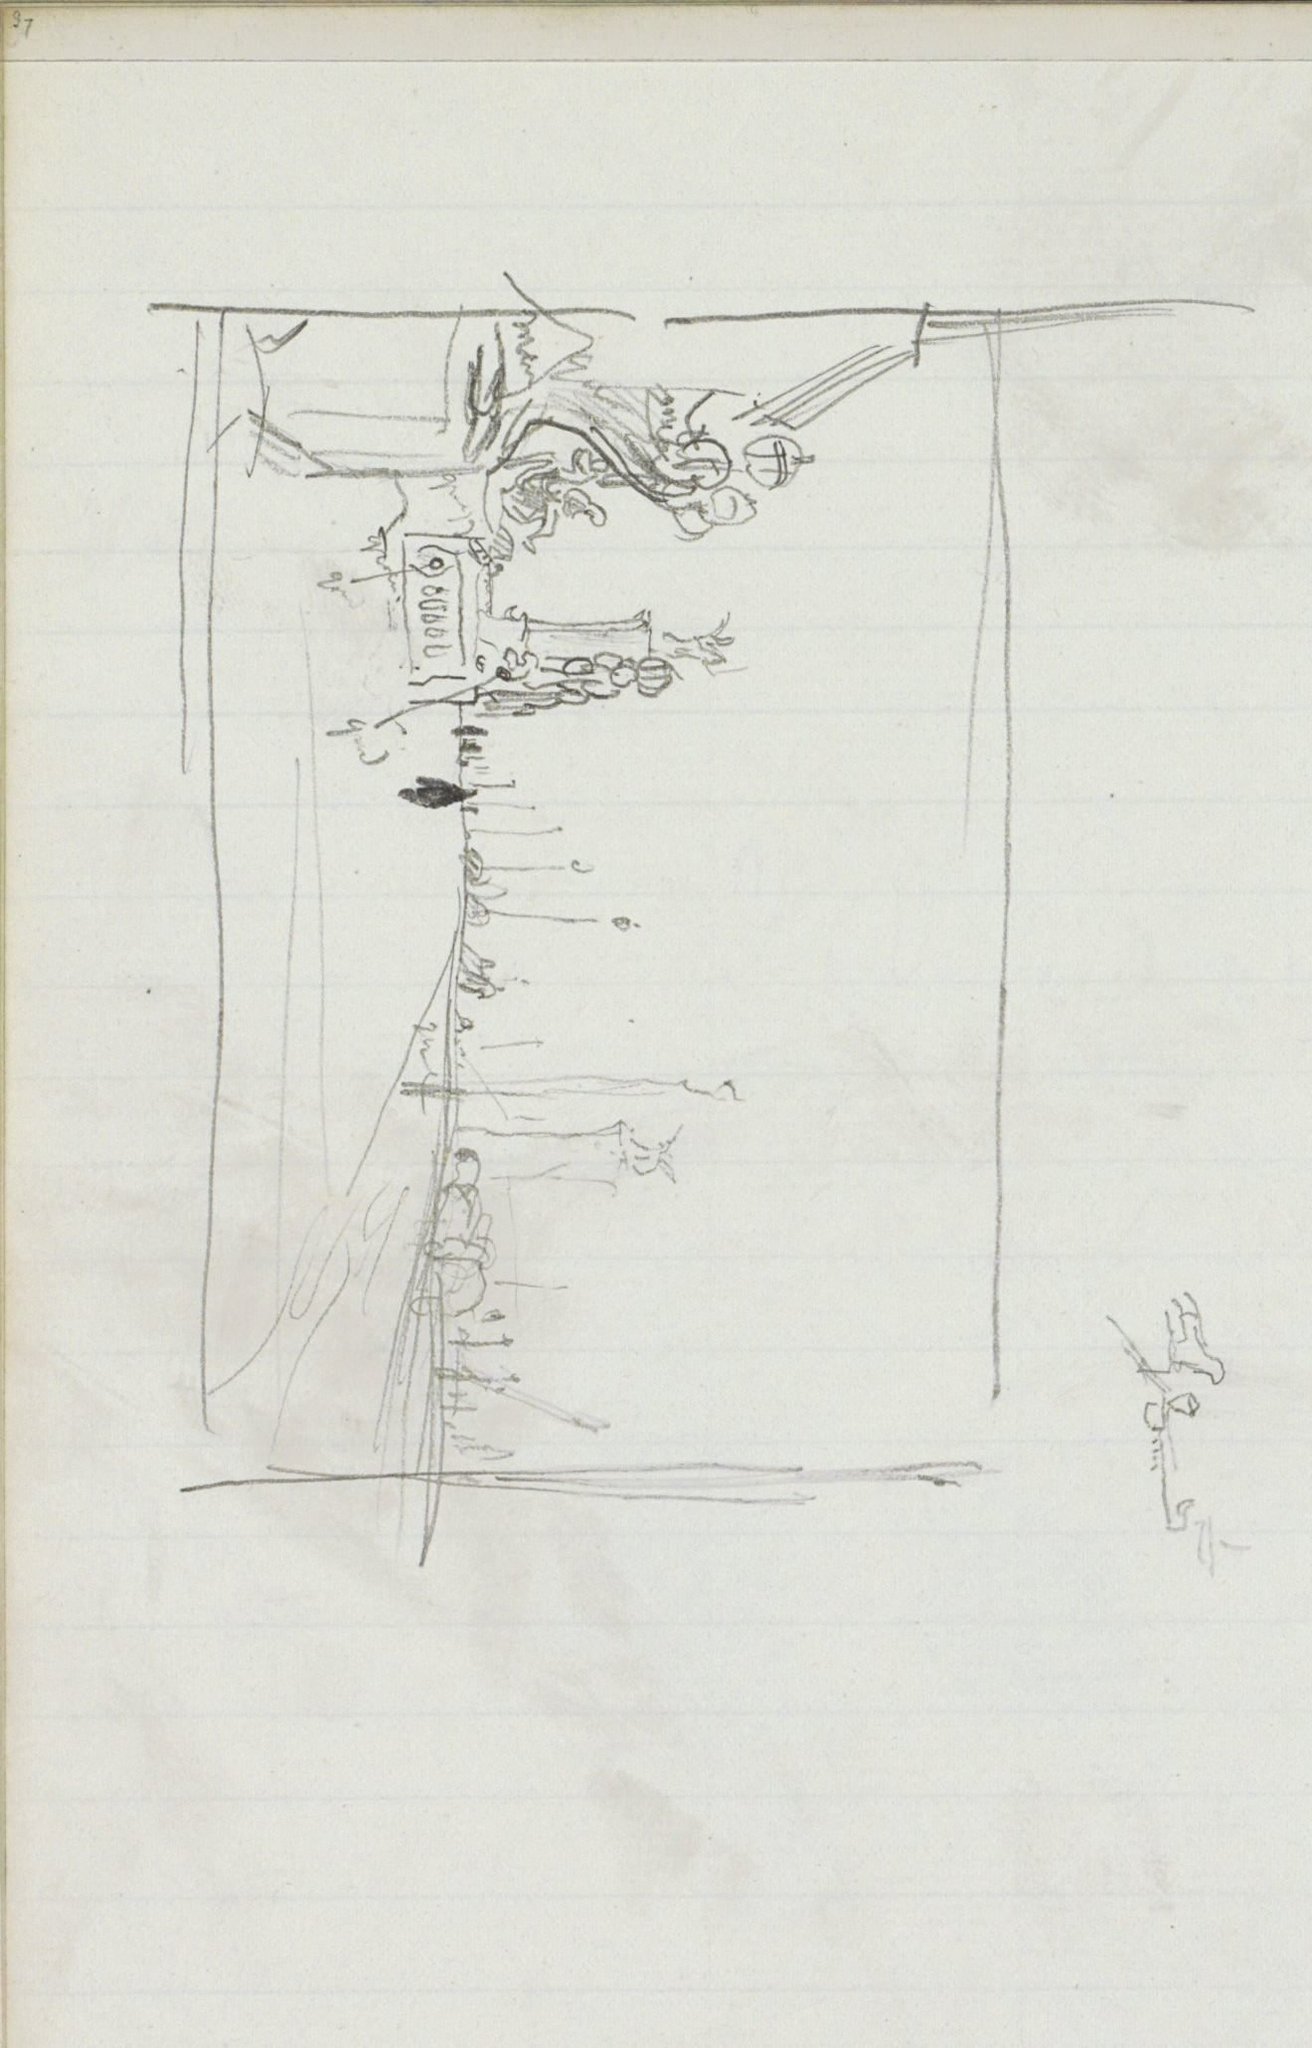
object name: sketchbook leaf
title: Pont Alexandre III, Parijs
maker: marius bauer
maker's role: draughtsman, print maker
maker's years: 1867-1932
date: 1877-1932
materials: pencil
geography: paris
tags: monument, statue, street lighting, bridge in city across river, canal, etc.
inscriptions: kleurnotitie, handgeschreven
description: Pagina 87 uit een schetsboek met 68 bladen.